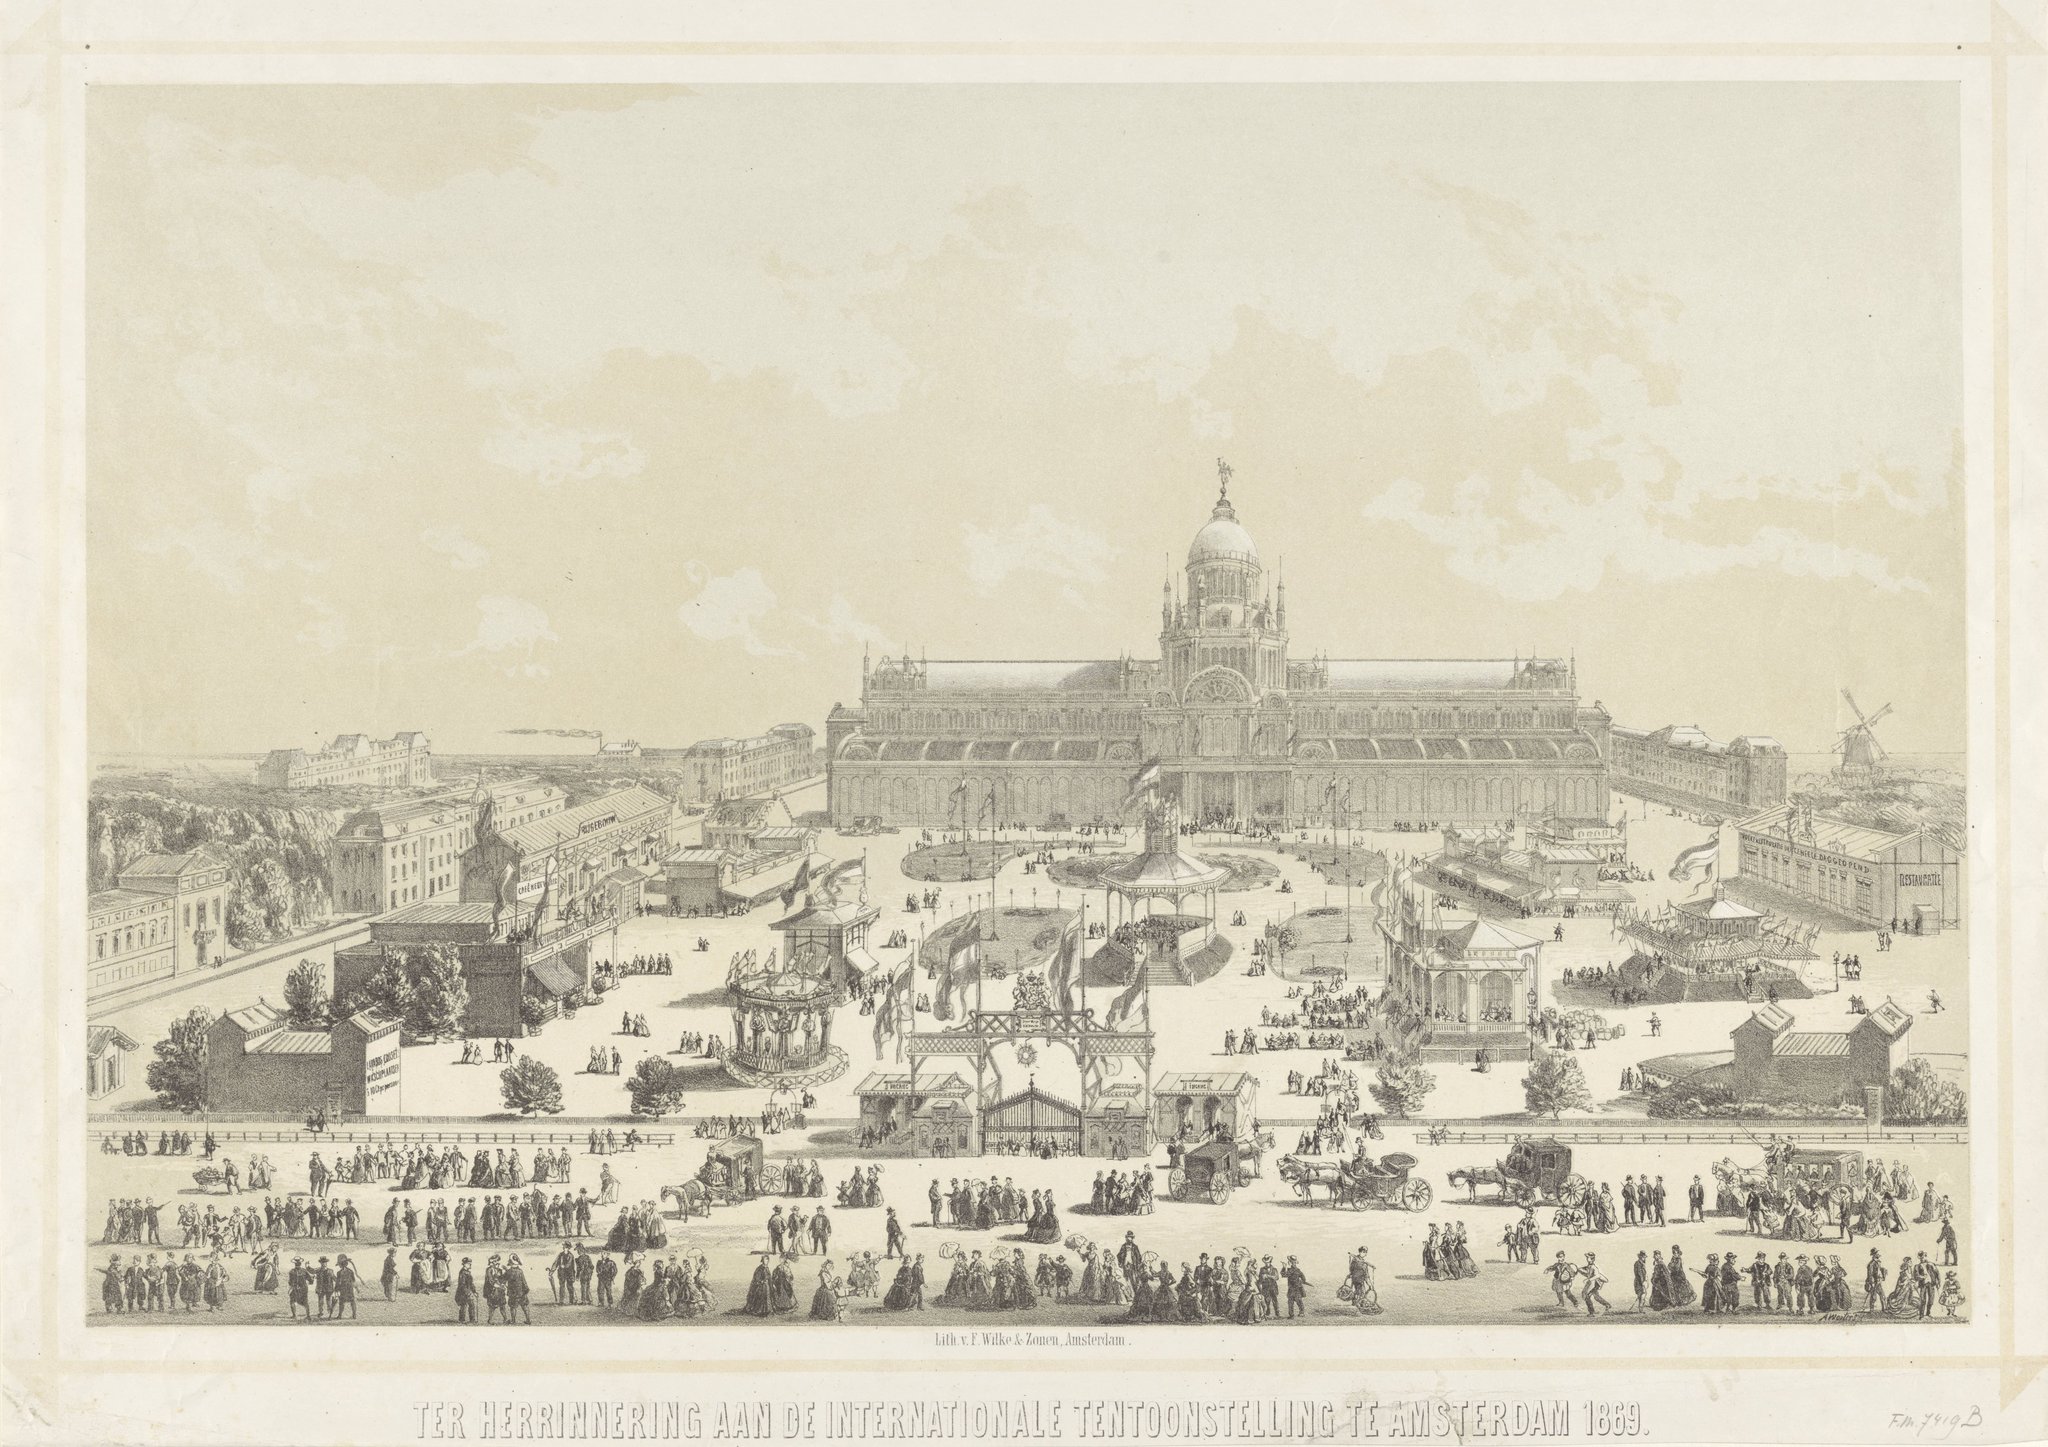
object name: print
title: Ter Herinnering aan de Internationale Tentoonstelling te Amsterdam 1869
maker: augustinus jacobus bernardus wouters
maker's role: print maker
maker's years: 1829-1904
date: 1869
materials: paper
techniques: tone lithography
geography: netherlands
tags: trade exhibition, industries fair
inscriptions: collector's mark: Lugt 2760, collector's mark: Lugt 2228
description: Gezicht vanuit het noorden op het Paleis voor Volksvlijt te Amsterdam met de Tentoonstelling van Kunst en Nijverheid in de tuin van het Paleis in 1869. Op het terrein allerlei gebouwen zoals een caroussel, restauraties, een badhuis etc. Op de voorgrond de ingangspoort. Links in de verte het Amstel-Hotel.